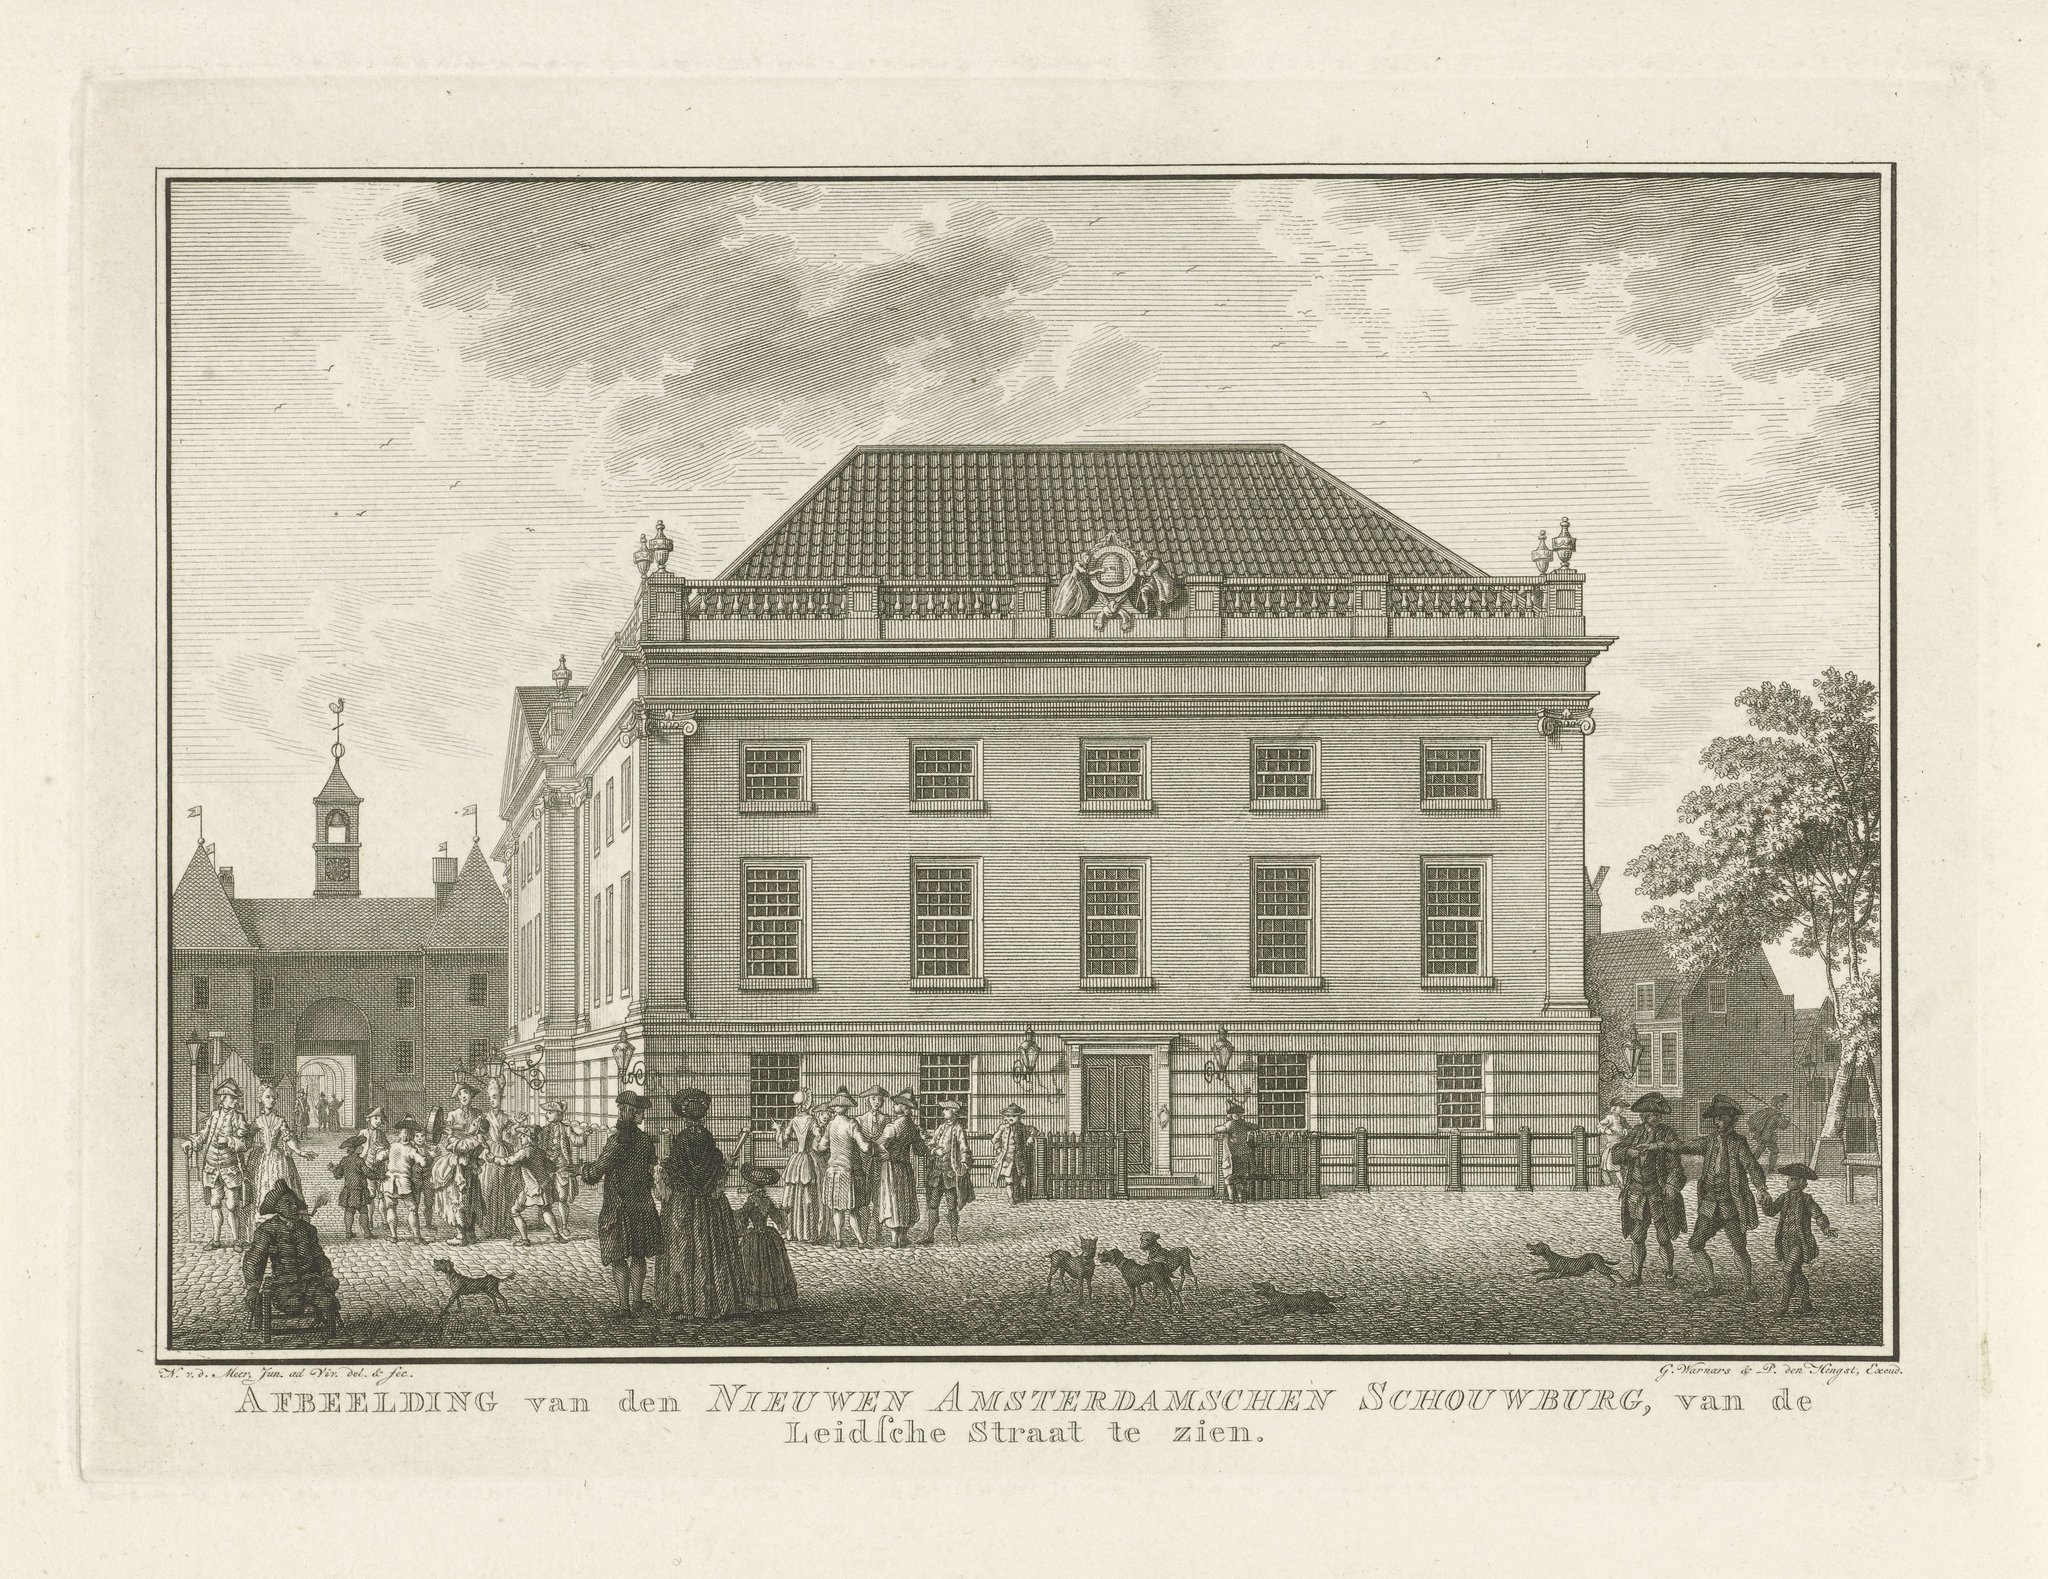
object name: print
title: Afbeelding van den Nieuwen Amsterdamschen Schouwburg, van de Leidsche Straat te zien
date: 1774-1775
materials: paper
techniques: engraving, etching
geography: amsterdam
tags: theatre (building), city-gate, square, place, circus, etc. (+ city(-scape) with figures, staffage)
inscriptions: collector's mark: Lugt 2228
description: Gezicht op de zijkant van de op 15 september 1774 ingewijde Amsterdamse Schouwburg op het Leidseplein, gezien vanuit de Leidsestraat. Links op de achtergrond de Leidsepoort. Deze stadsschouwburg werd gebouwd om de in 1772 afgebrande schouwburg aan de Keizersgracht te vervangen en brandde in 1890 zelf af. Links op de voorgrond zit Swarte Klaas op zijn krukje pijp te roken. Rechts achter hem staat Prulla, een ander bekend straatfiguur uit die tijd, met haar spreektrompet.